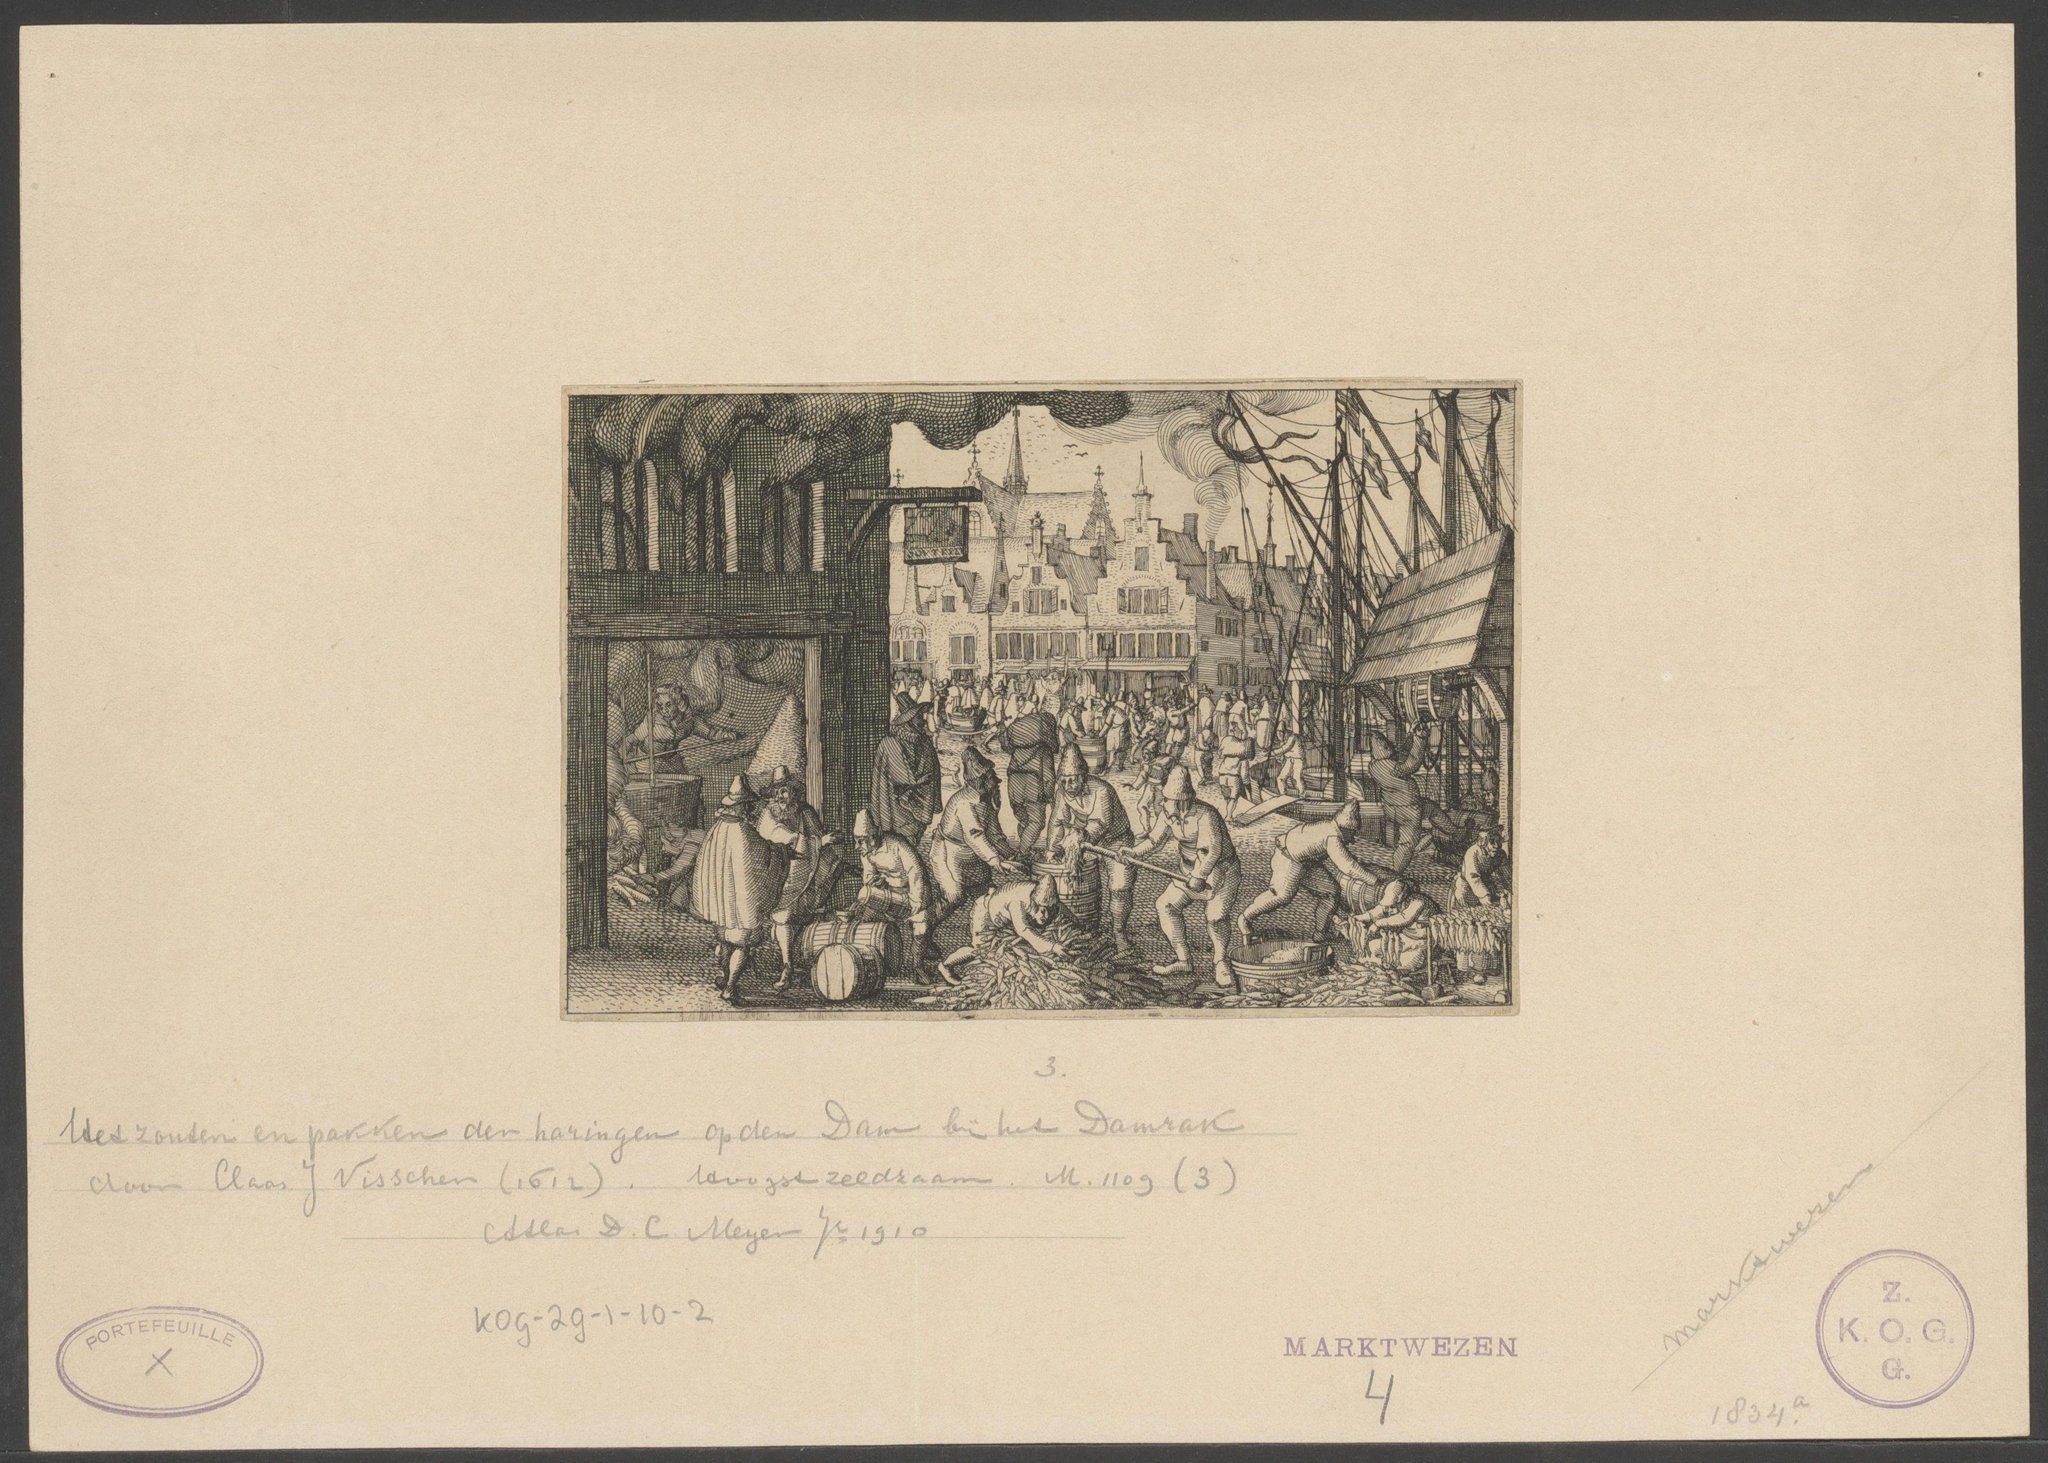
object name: print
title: Haring pakken en roken bij de Haringpakkerstoren, ca. 1600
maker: claes jansz. visscher (ii)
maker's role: draughtsman, print maker, publisher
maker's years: 1586-1652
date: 1608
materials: paper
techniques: etching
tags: salt, storing, conserving, preserving (of products), herring fishery, fish; still life of fishes, amsterdam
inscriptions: collector's mark: Lugt 1641, collector's mark: Lugt 963, stamp:, stamp:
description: Haring pakken en roken bij de Haringpakkerstoren, ca. 1600. Het kaken, roken en pakken van haring. Op de voorgrond rechts wordt de haring gekaakt. Links een haringrokerij met uithangbord met de naam Souterij. In het midden wordt de haring in tonnen gepakt. Een andere staat is No. 3 uit serie beroepen in Noord-Holland. Onderwerpsrubrieken binnen de Atlas Zeden en Gewoonten: Handel, nijverheid en verkeer, Marktwezen, Amsterdam.